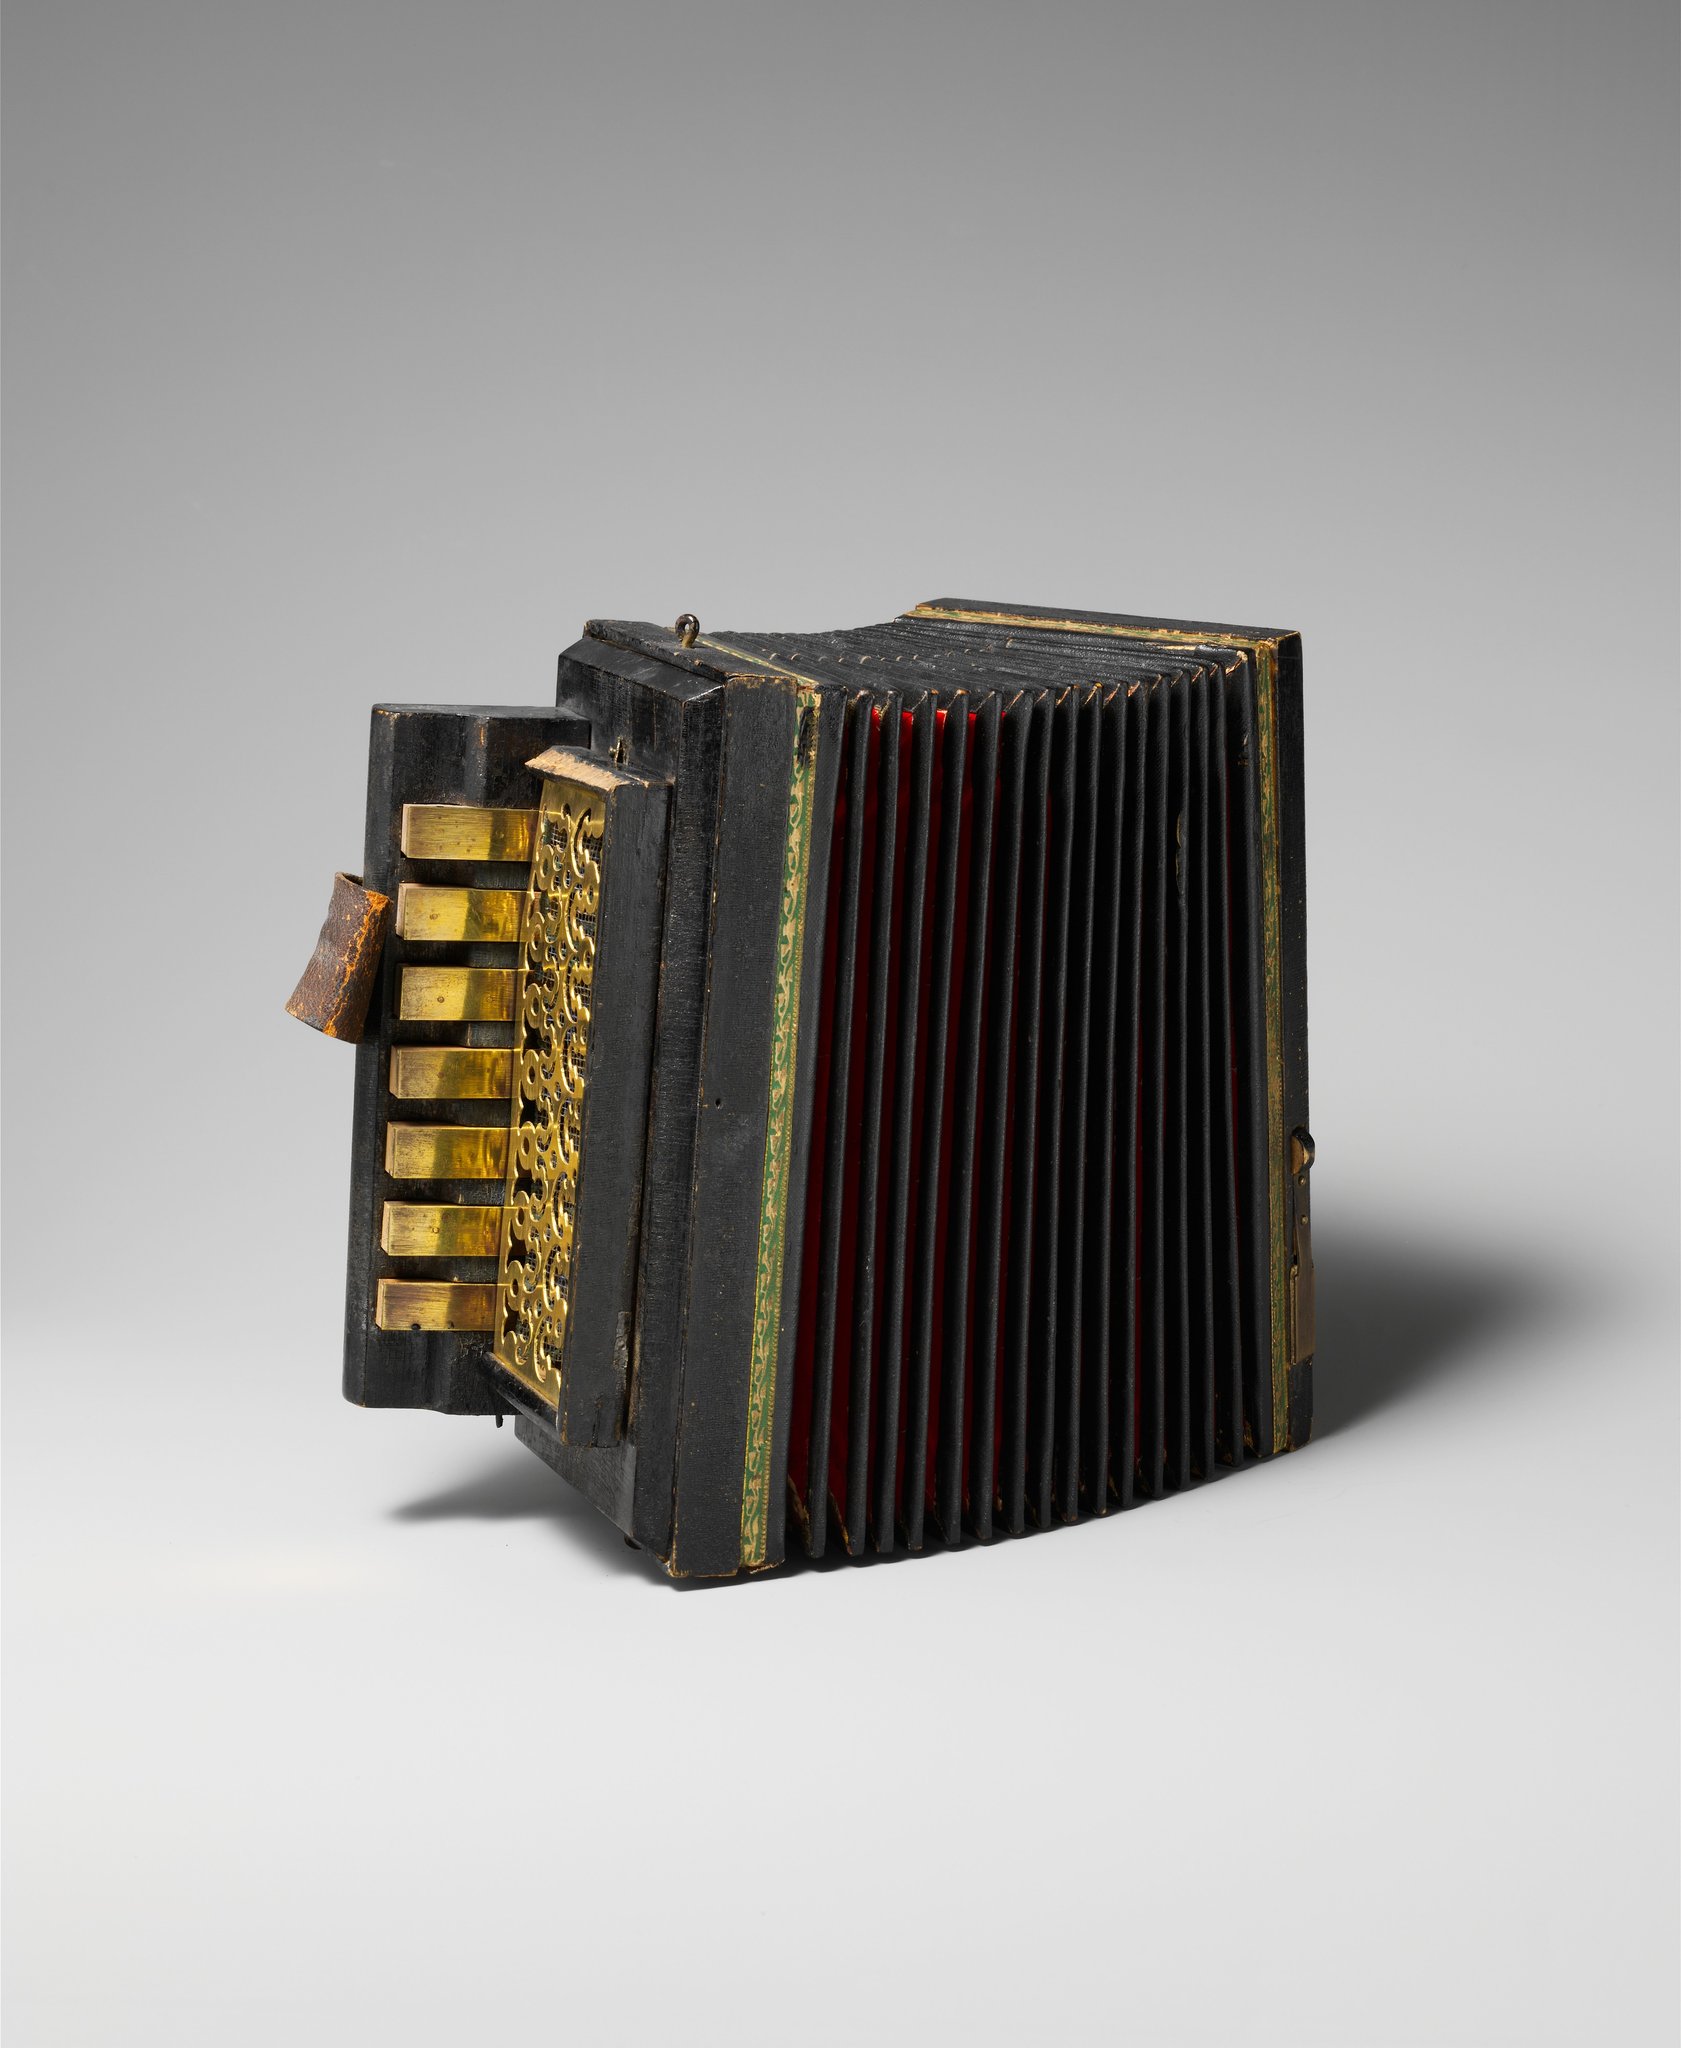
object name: accordion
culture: russian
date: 1870-1880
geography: russia